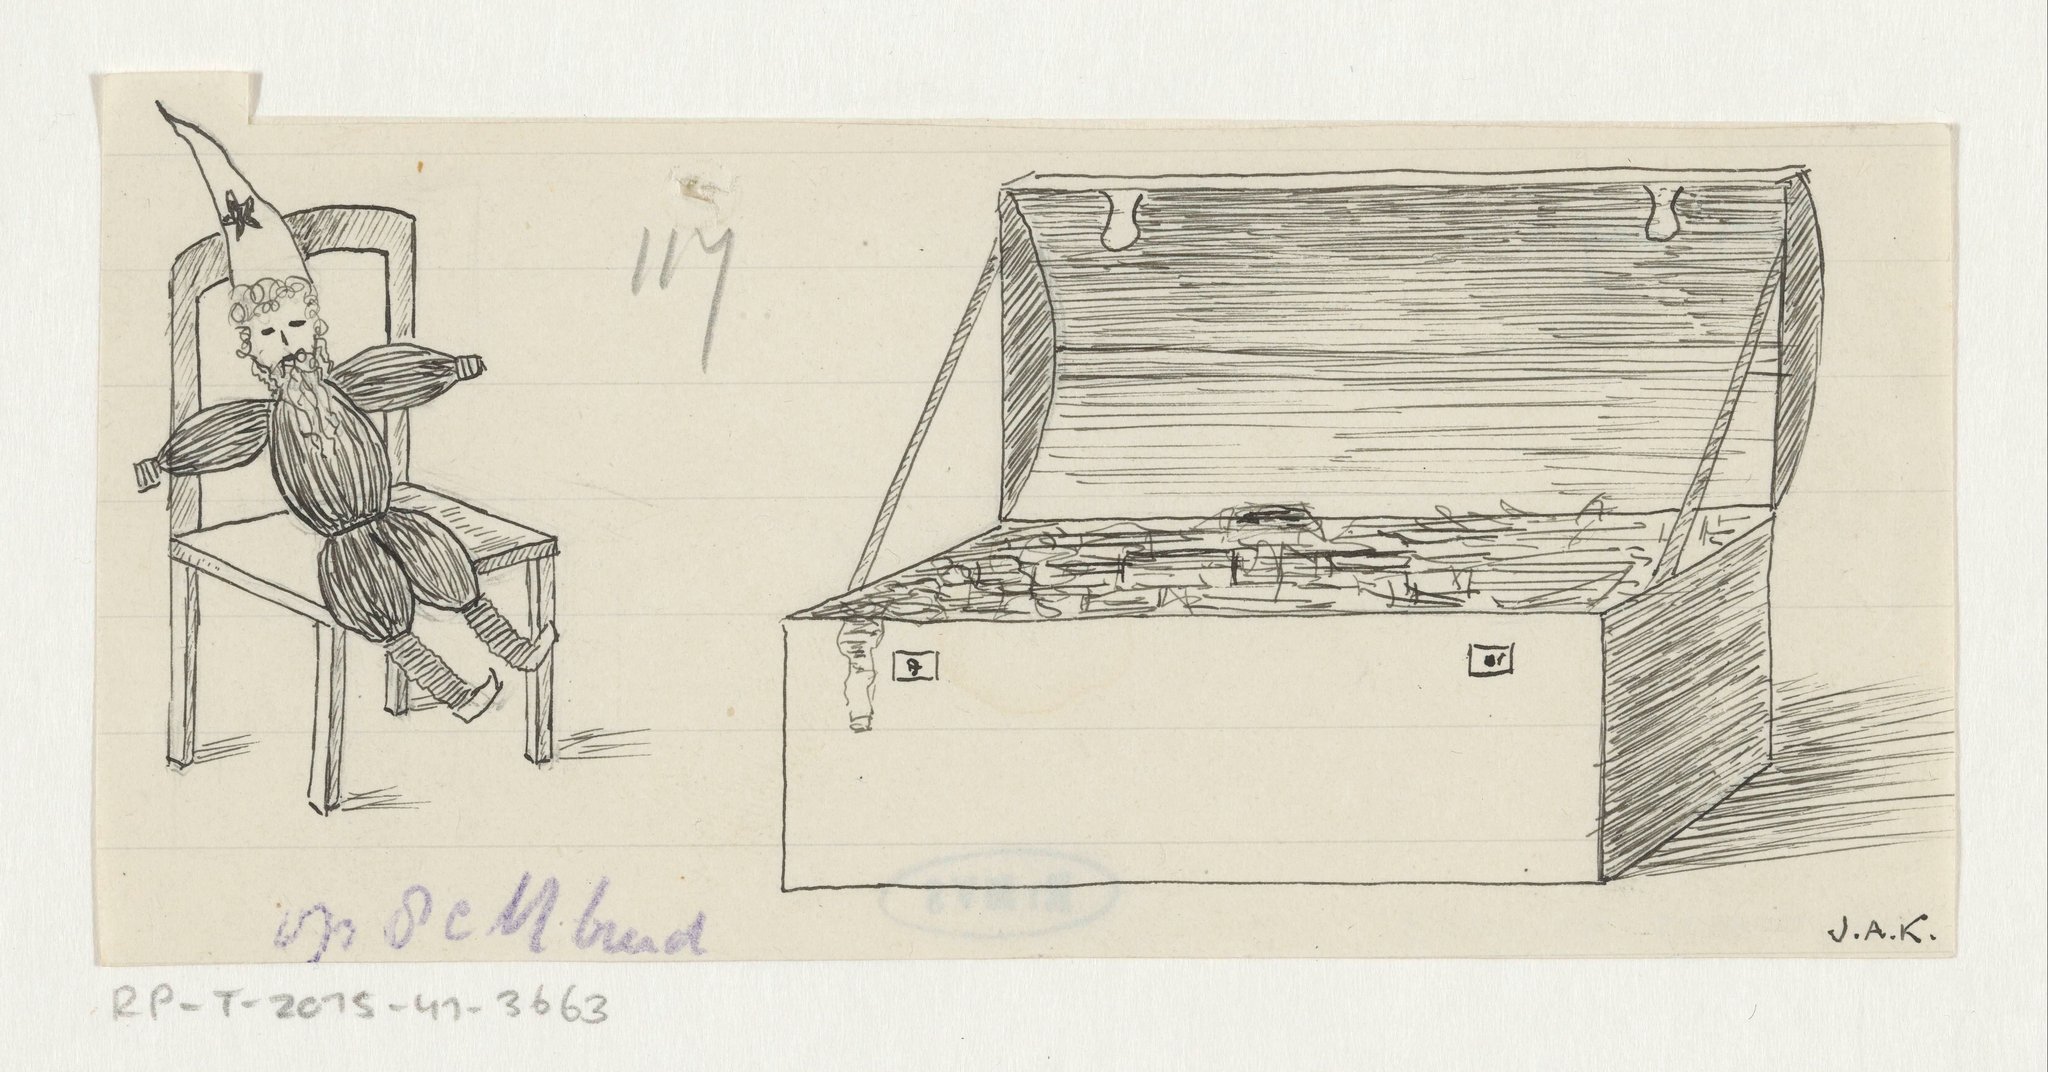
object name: drawing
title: Pop op een stoel naast een kist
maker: Anonymous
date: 1880-1930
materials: ink, pencil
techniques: pen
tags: (playing with) dolls, chest, coffer, chair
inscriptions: collector's mark: Lugt 2228a, :, signature: ‘J.A.K.’, annotation: ‘Febr. Pag. 1.’, number: ‘117’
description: Een lappenpop met een baard en puntmuts met een ster zit op een stoel naast een geopende kist.